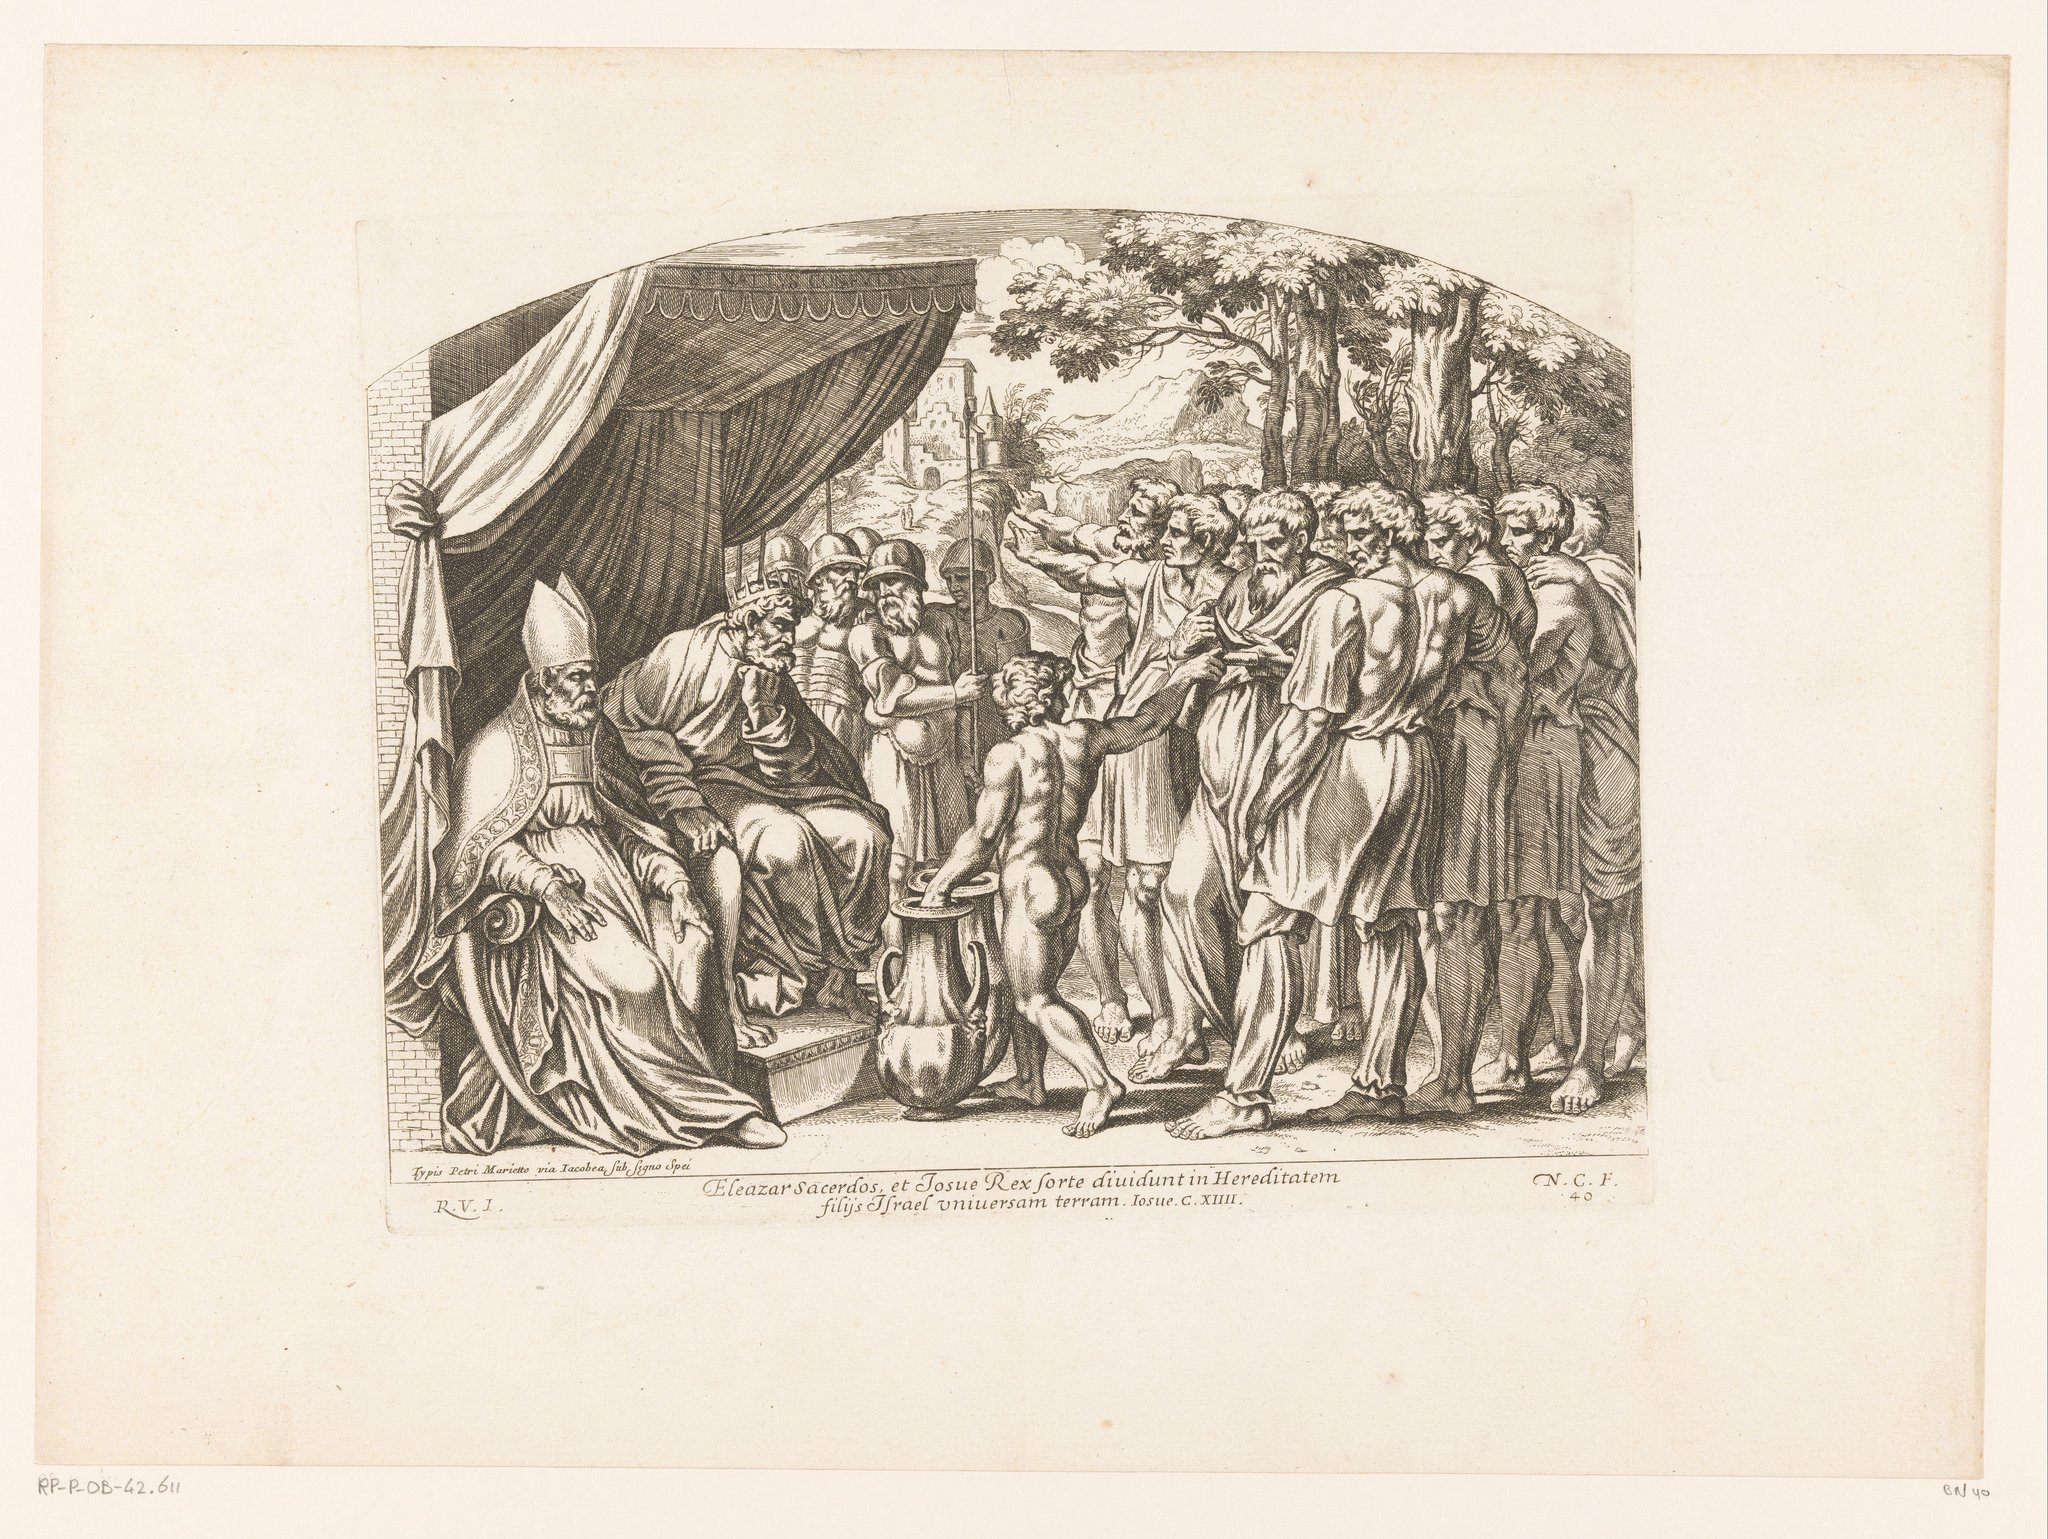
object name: print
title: Rafaël Bijbel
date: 1649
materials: paper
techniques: etching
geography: vatican city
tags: by drawing lots, joshua, eleazar and the leaders of the tribes of israel assign cities to the levites (joshua 21)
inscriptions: collector's mark: Lugt 2228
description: Prent uit de Sacrae Historiae Acta a Raphael Urbin in Vaticanis xystis ad picturae miraculum expressa, ook bekend als de Rafaël Bijbel. De serie bestaat uit 54 platen, waarvan twee titelprenten, de eerste met een opdracht aan Rafaël, de tweede met een opdracht aan Renard. De overige 52 platen betreffen composities naar schilderingen in de Loggia van Rafaël in het Vaticaan. De serie werd in 1649 uitgegeven door Pierre Mariette te Parijs.